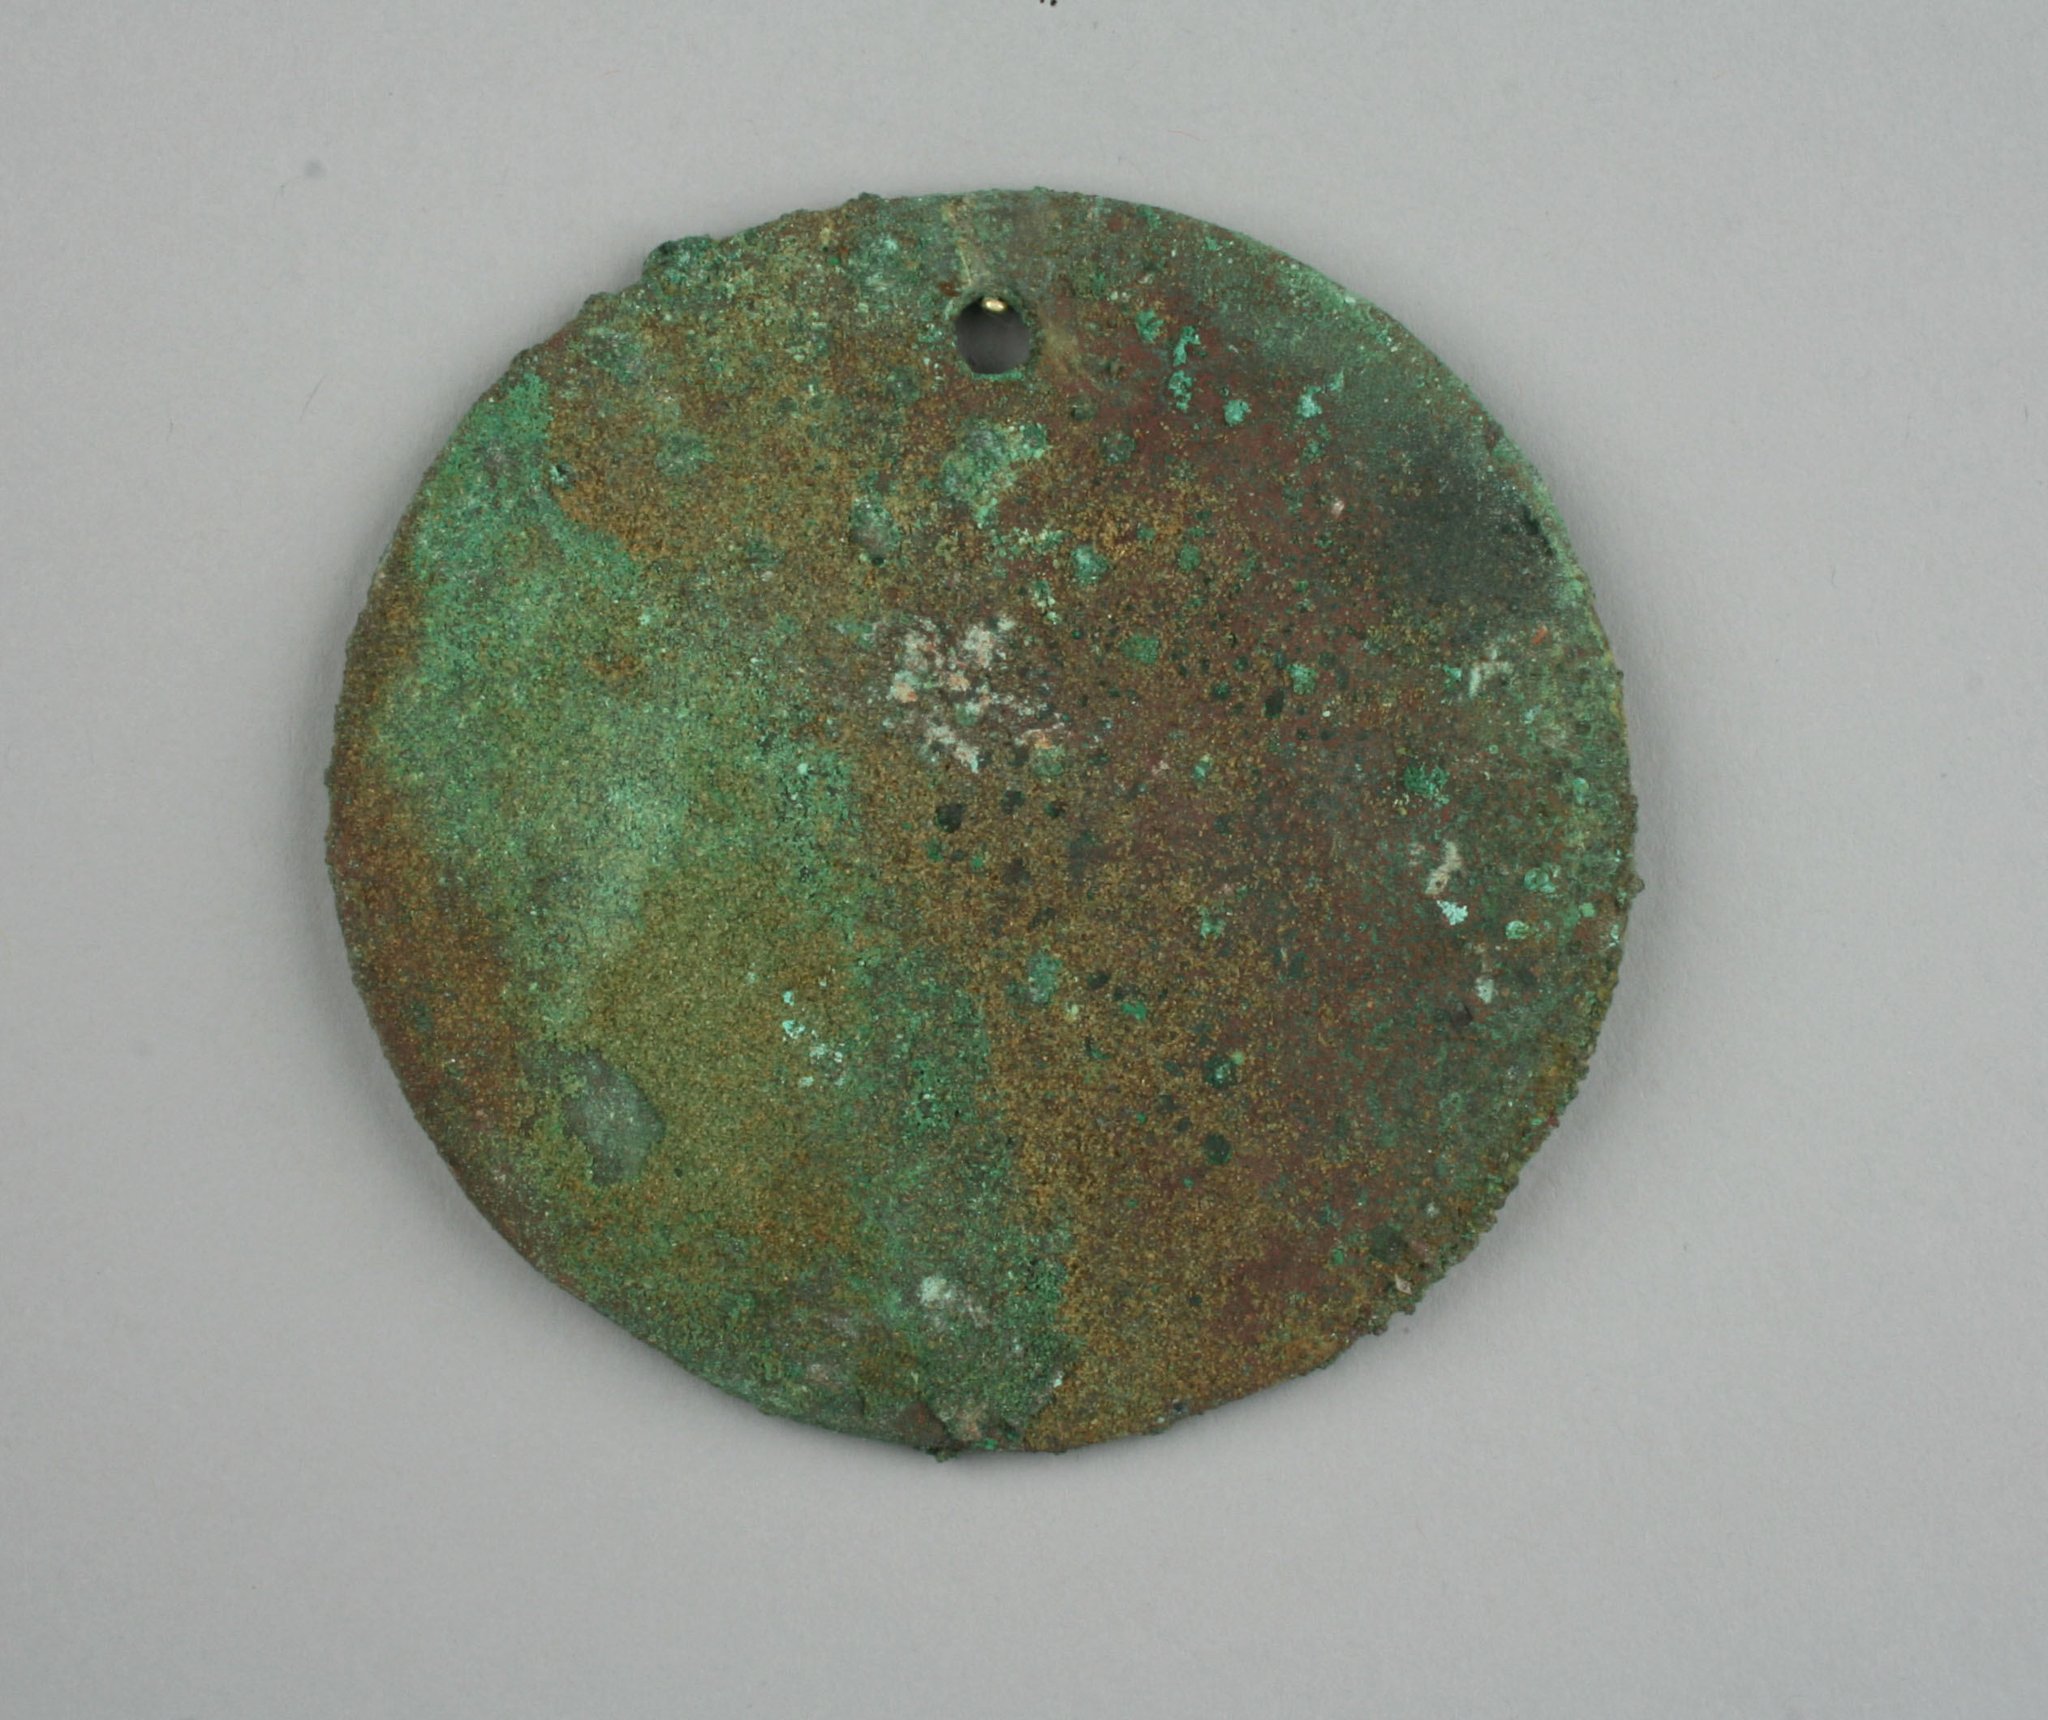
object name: plaque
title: Round Plaque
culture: vicús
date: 300 BCE-200 CE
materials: copper, gilt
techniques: hammering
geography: peru